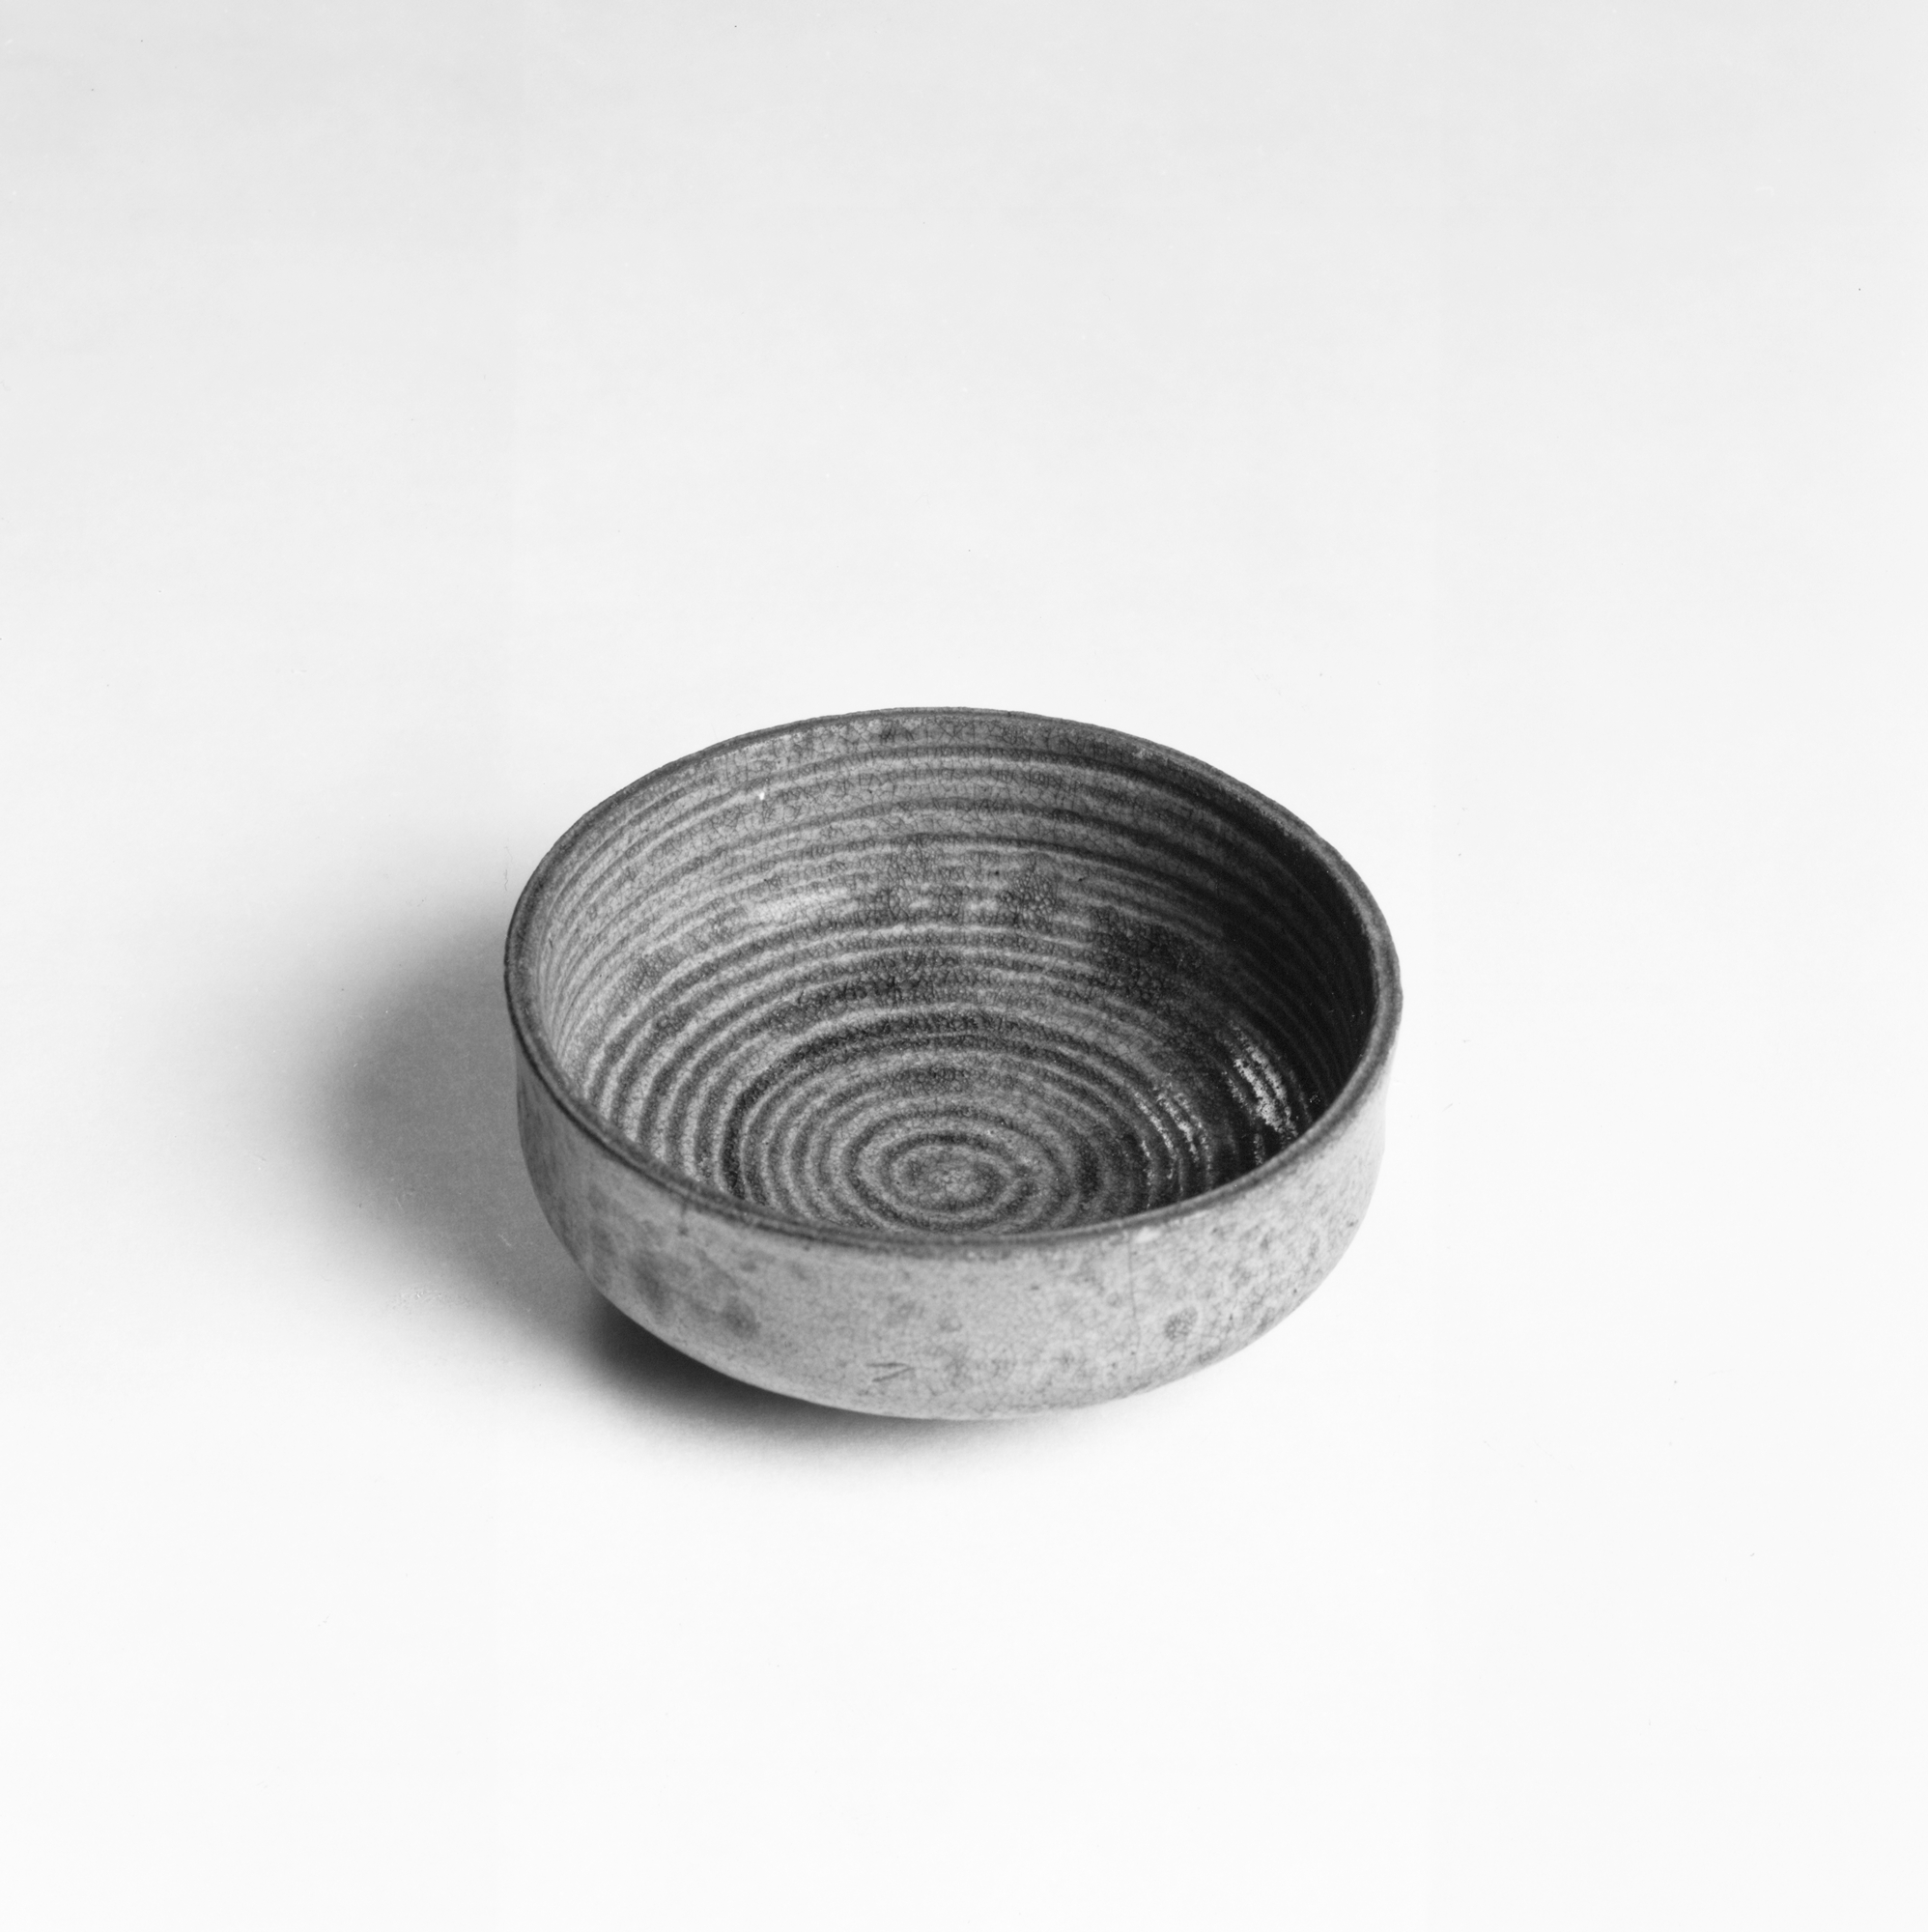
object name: bowl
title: Bowl (Yu)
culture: chinese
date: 700-401 BCE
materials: glaze, stoneware